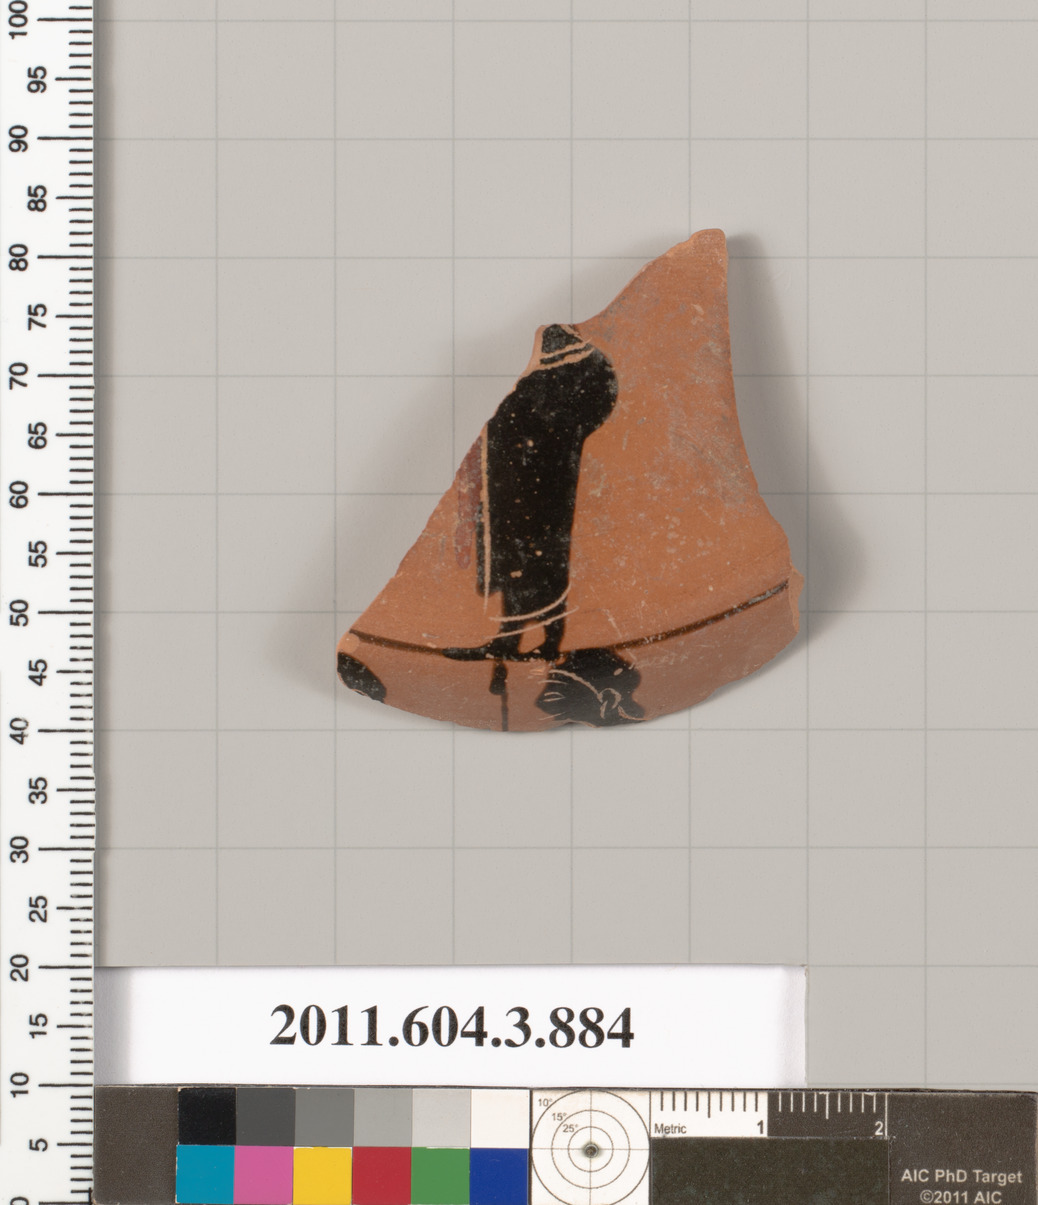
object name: lekythos fragment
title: Terracotta fragment of a lekythos (oil flask)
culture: greek, attic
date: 534-501 BCE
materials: terracotta